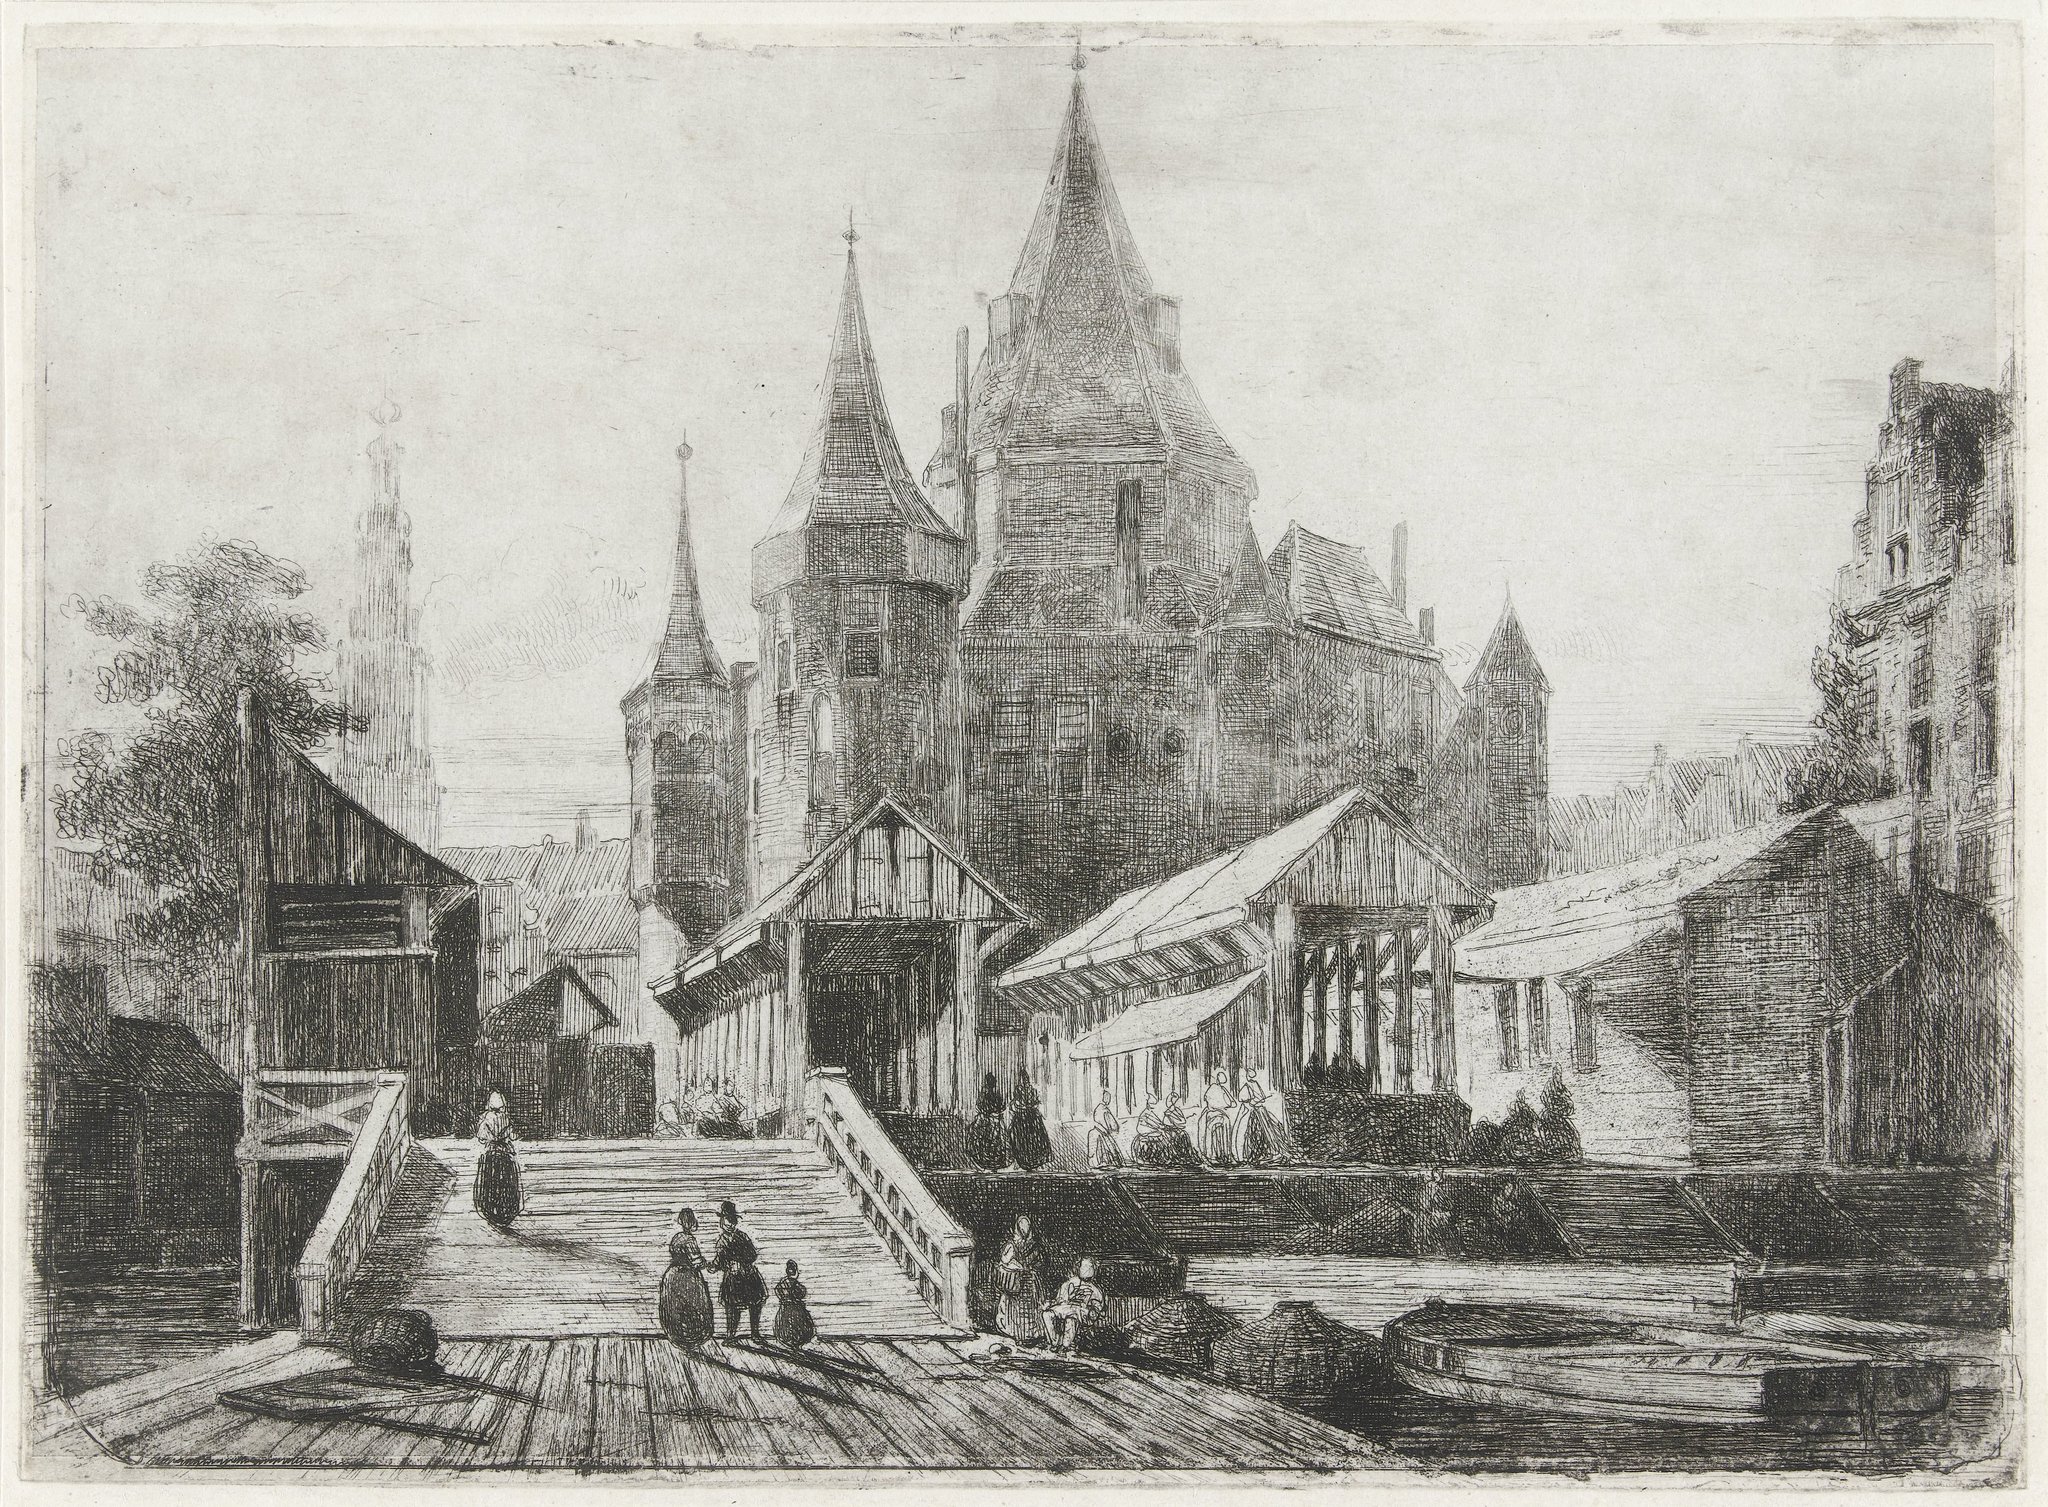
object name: print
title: Gezicht op de Nieuwmarkt te Amsterdam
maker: lambertus hardenberg (1822-1900)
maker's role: draughtsman, painter, print maker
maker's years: 1822-1900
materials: paper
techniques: etching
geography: the hague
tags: market, bridge, weigh-house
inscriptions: collector's mark: Lugt 2228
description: Gezicht op de Nieuwmarkt in Amsterdam, met op de voorgrond figuren bij een houten brug en markthallen, op de achtergrond de Waag of de St. Anthonispoort en de toren van de Zuiderkerk.